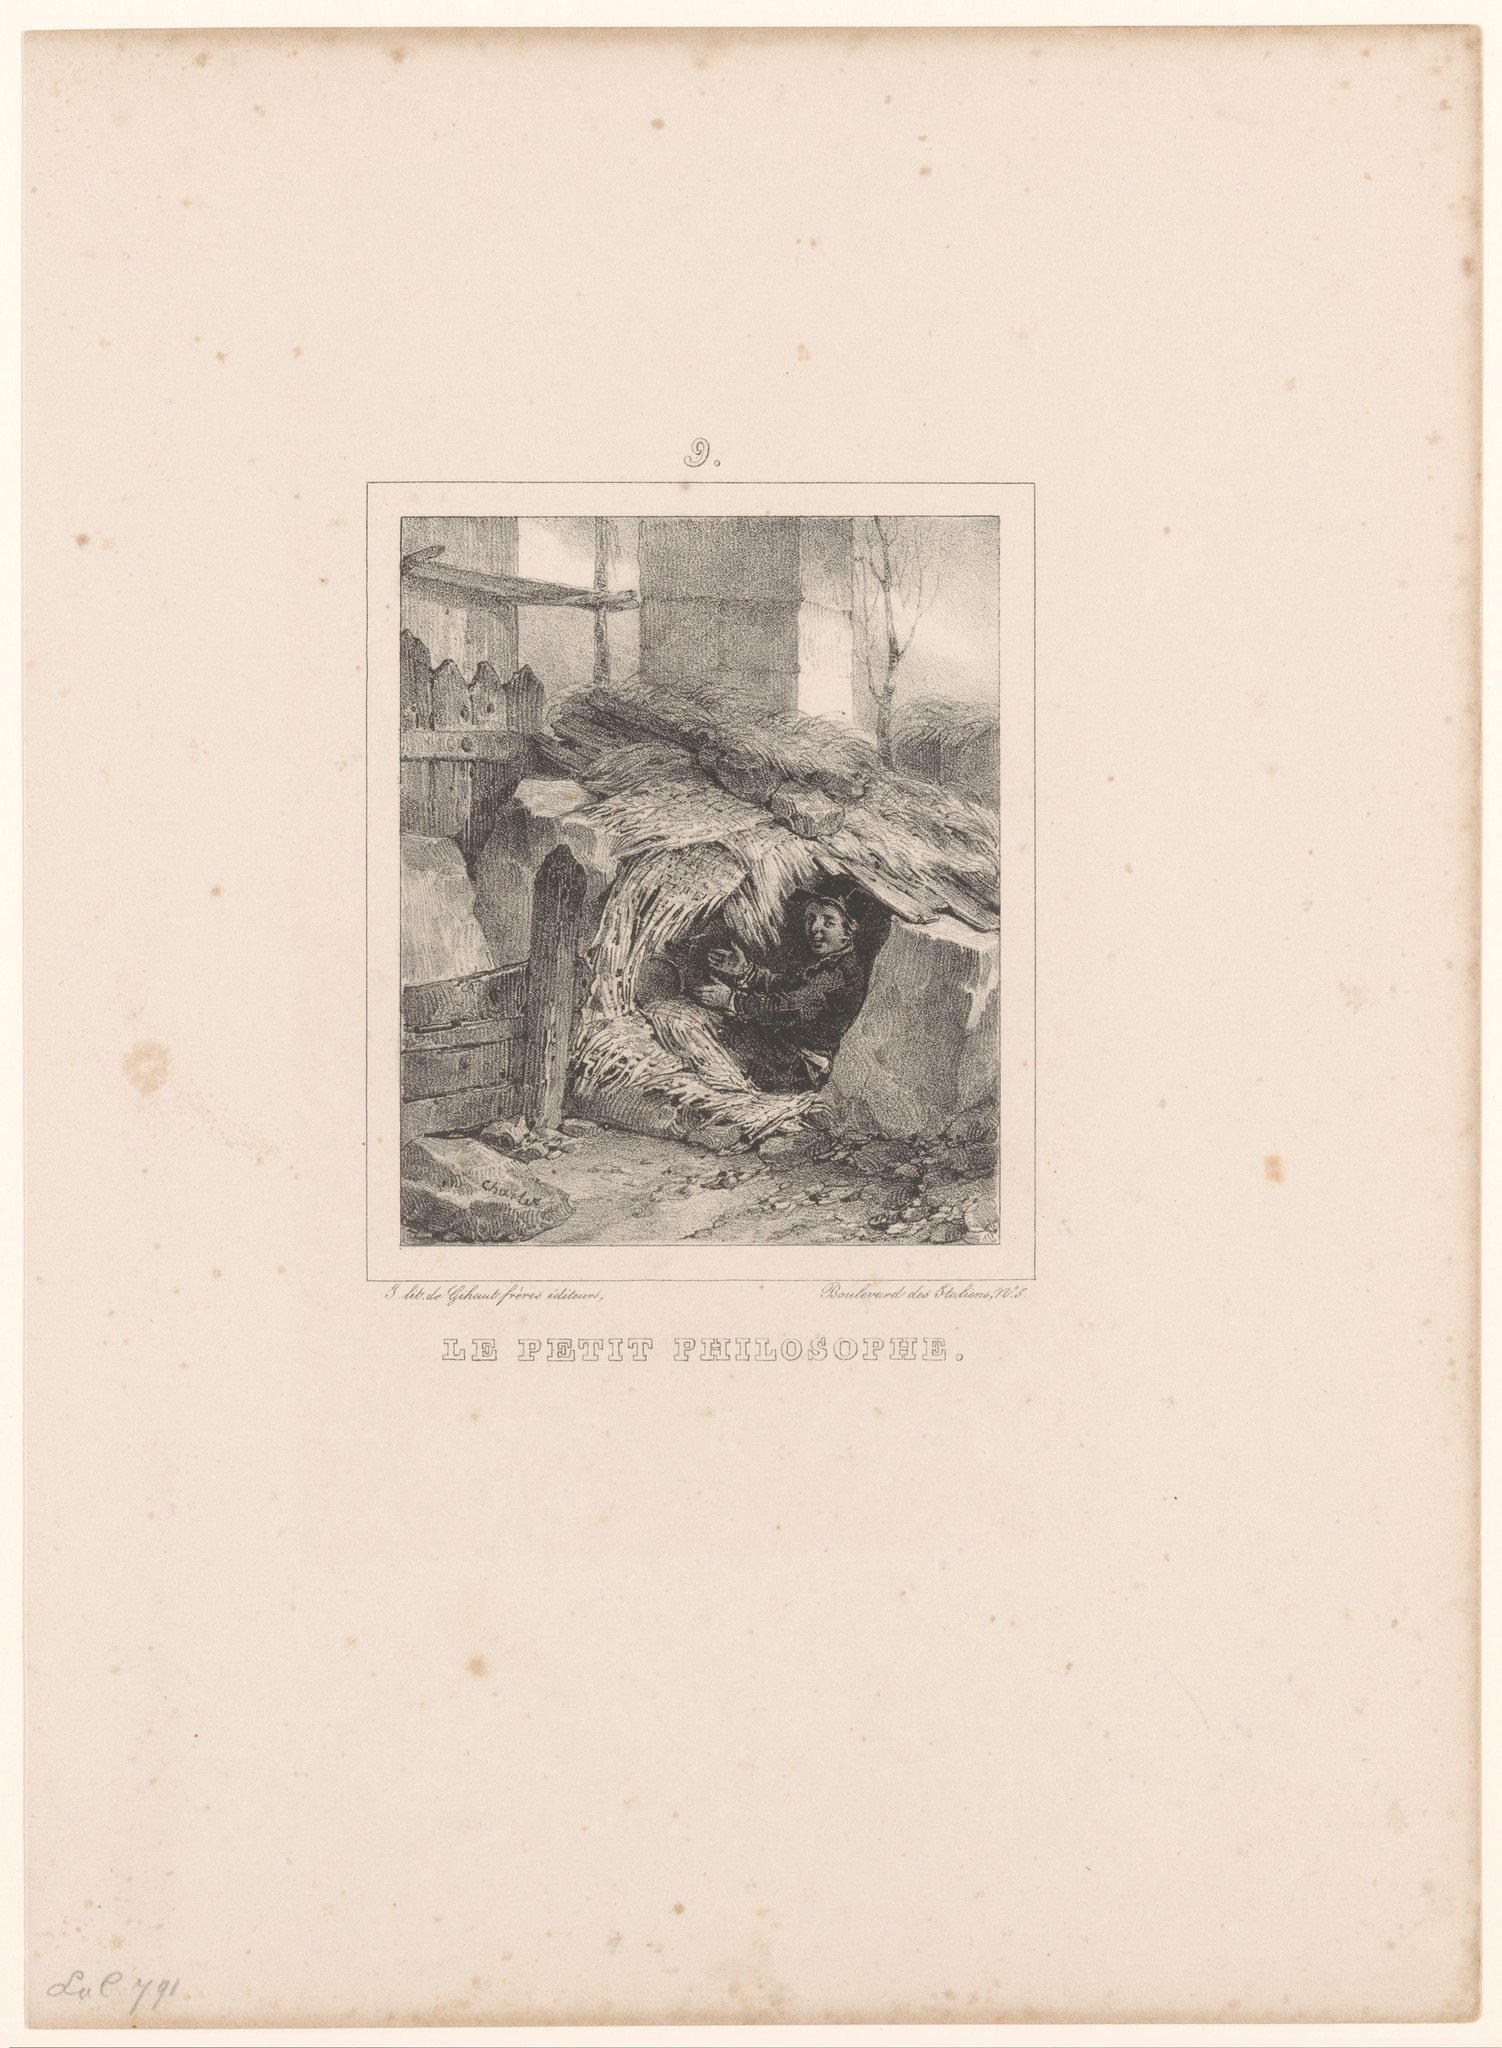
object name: print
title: Lithografisch album 1832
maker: nicolas toussaint charlet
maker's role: draughtsman, painter, print maker, printer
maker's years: 1792-1845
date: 1832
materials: paper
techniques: lithograph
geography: paris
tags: other children's games, boy (child between toddler and youth), hut, cabin, lodge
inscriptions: collector's mark: Lugt 2228a